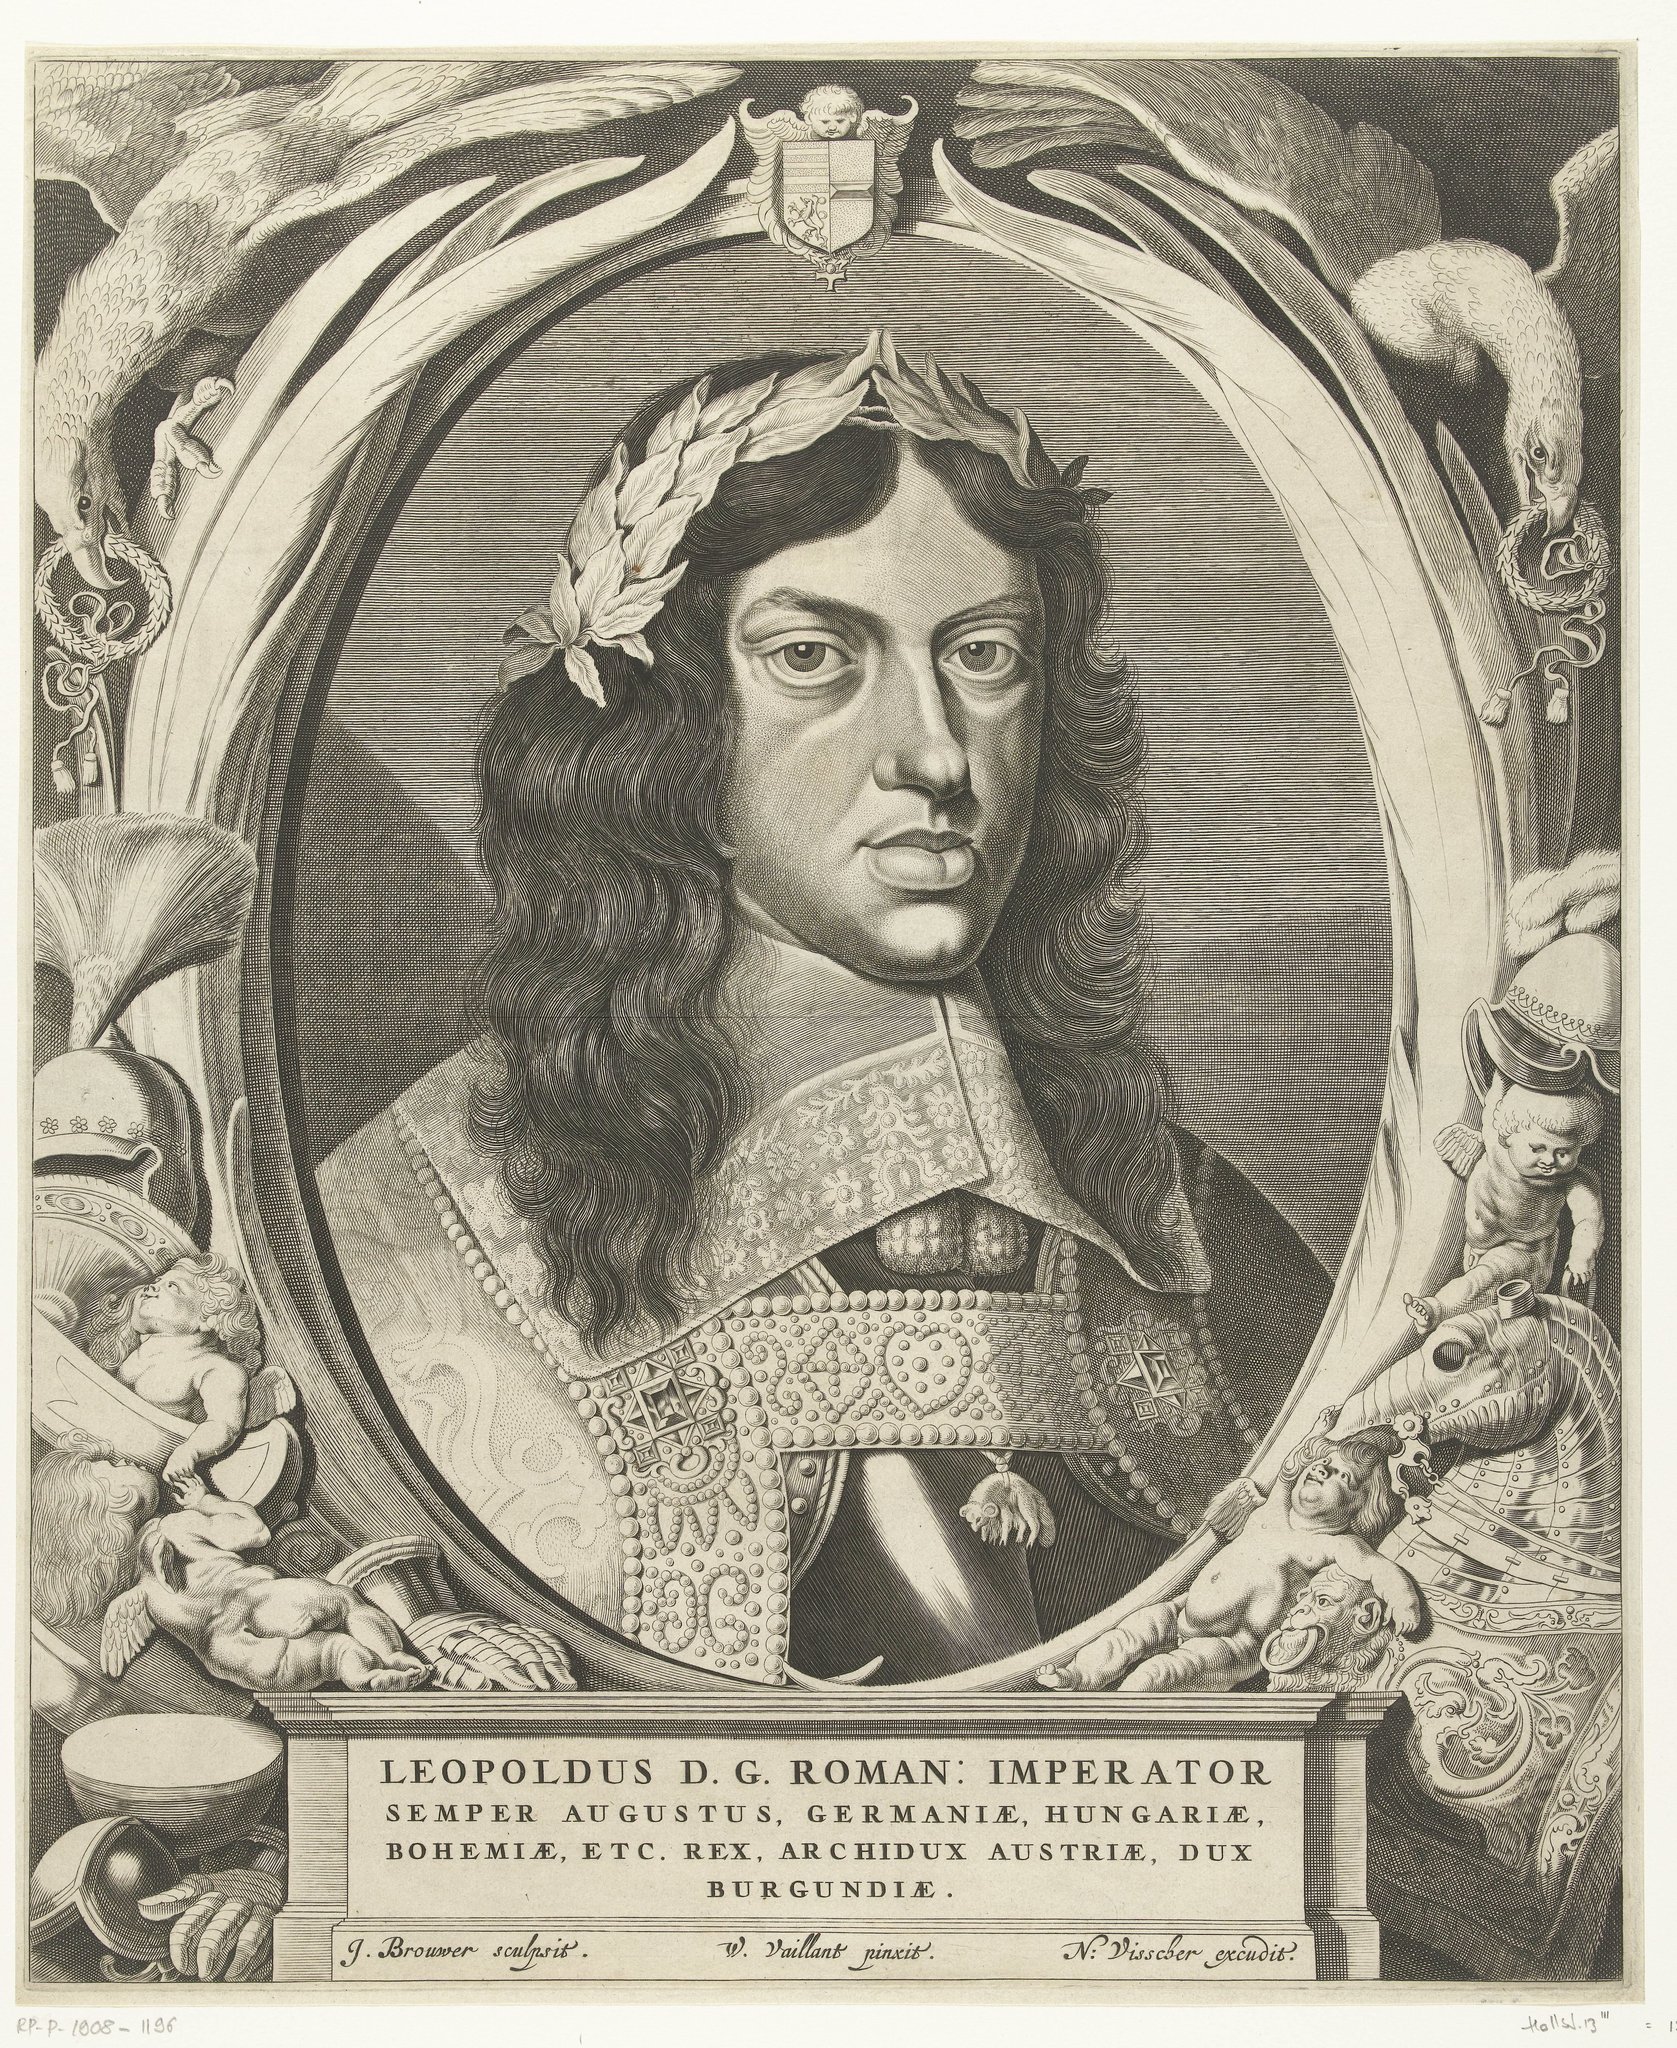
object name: print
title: Portret van keizer Leopold I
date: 1658-1688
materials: paper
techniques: engraving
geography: amsterdam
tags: vienna, leopold i (keizer van duitsland), knighthood order of the golden fleece - insignia of a knighthood order, e.g.: badge, chain (with name of order)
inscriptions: collector's mark: Lugt 2228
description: Portret van de keizer Leopold I met lauwerkrans in het haar. Leopold draagt de ketting van het Gulden Vlies om zijn hals. Met een ornamentele lijst uit putti, adelaars en onderdelen van een wapenrusting. Onder het portret zijn naam en titels.